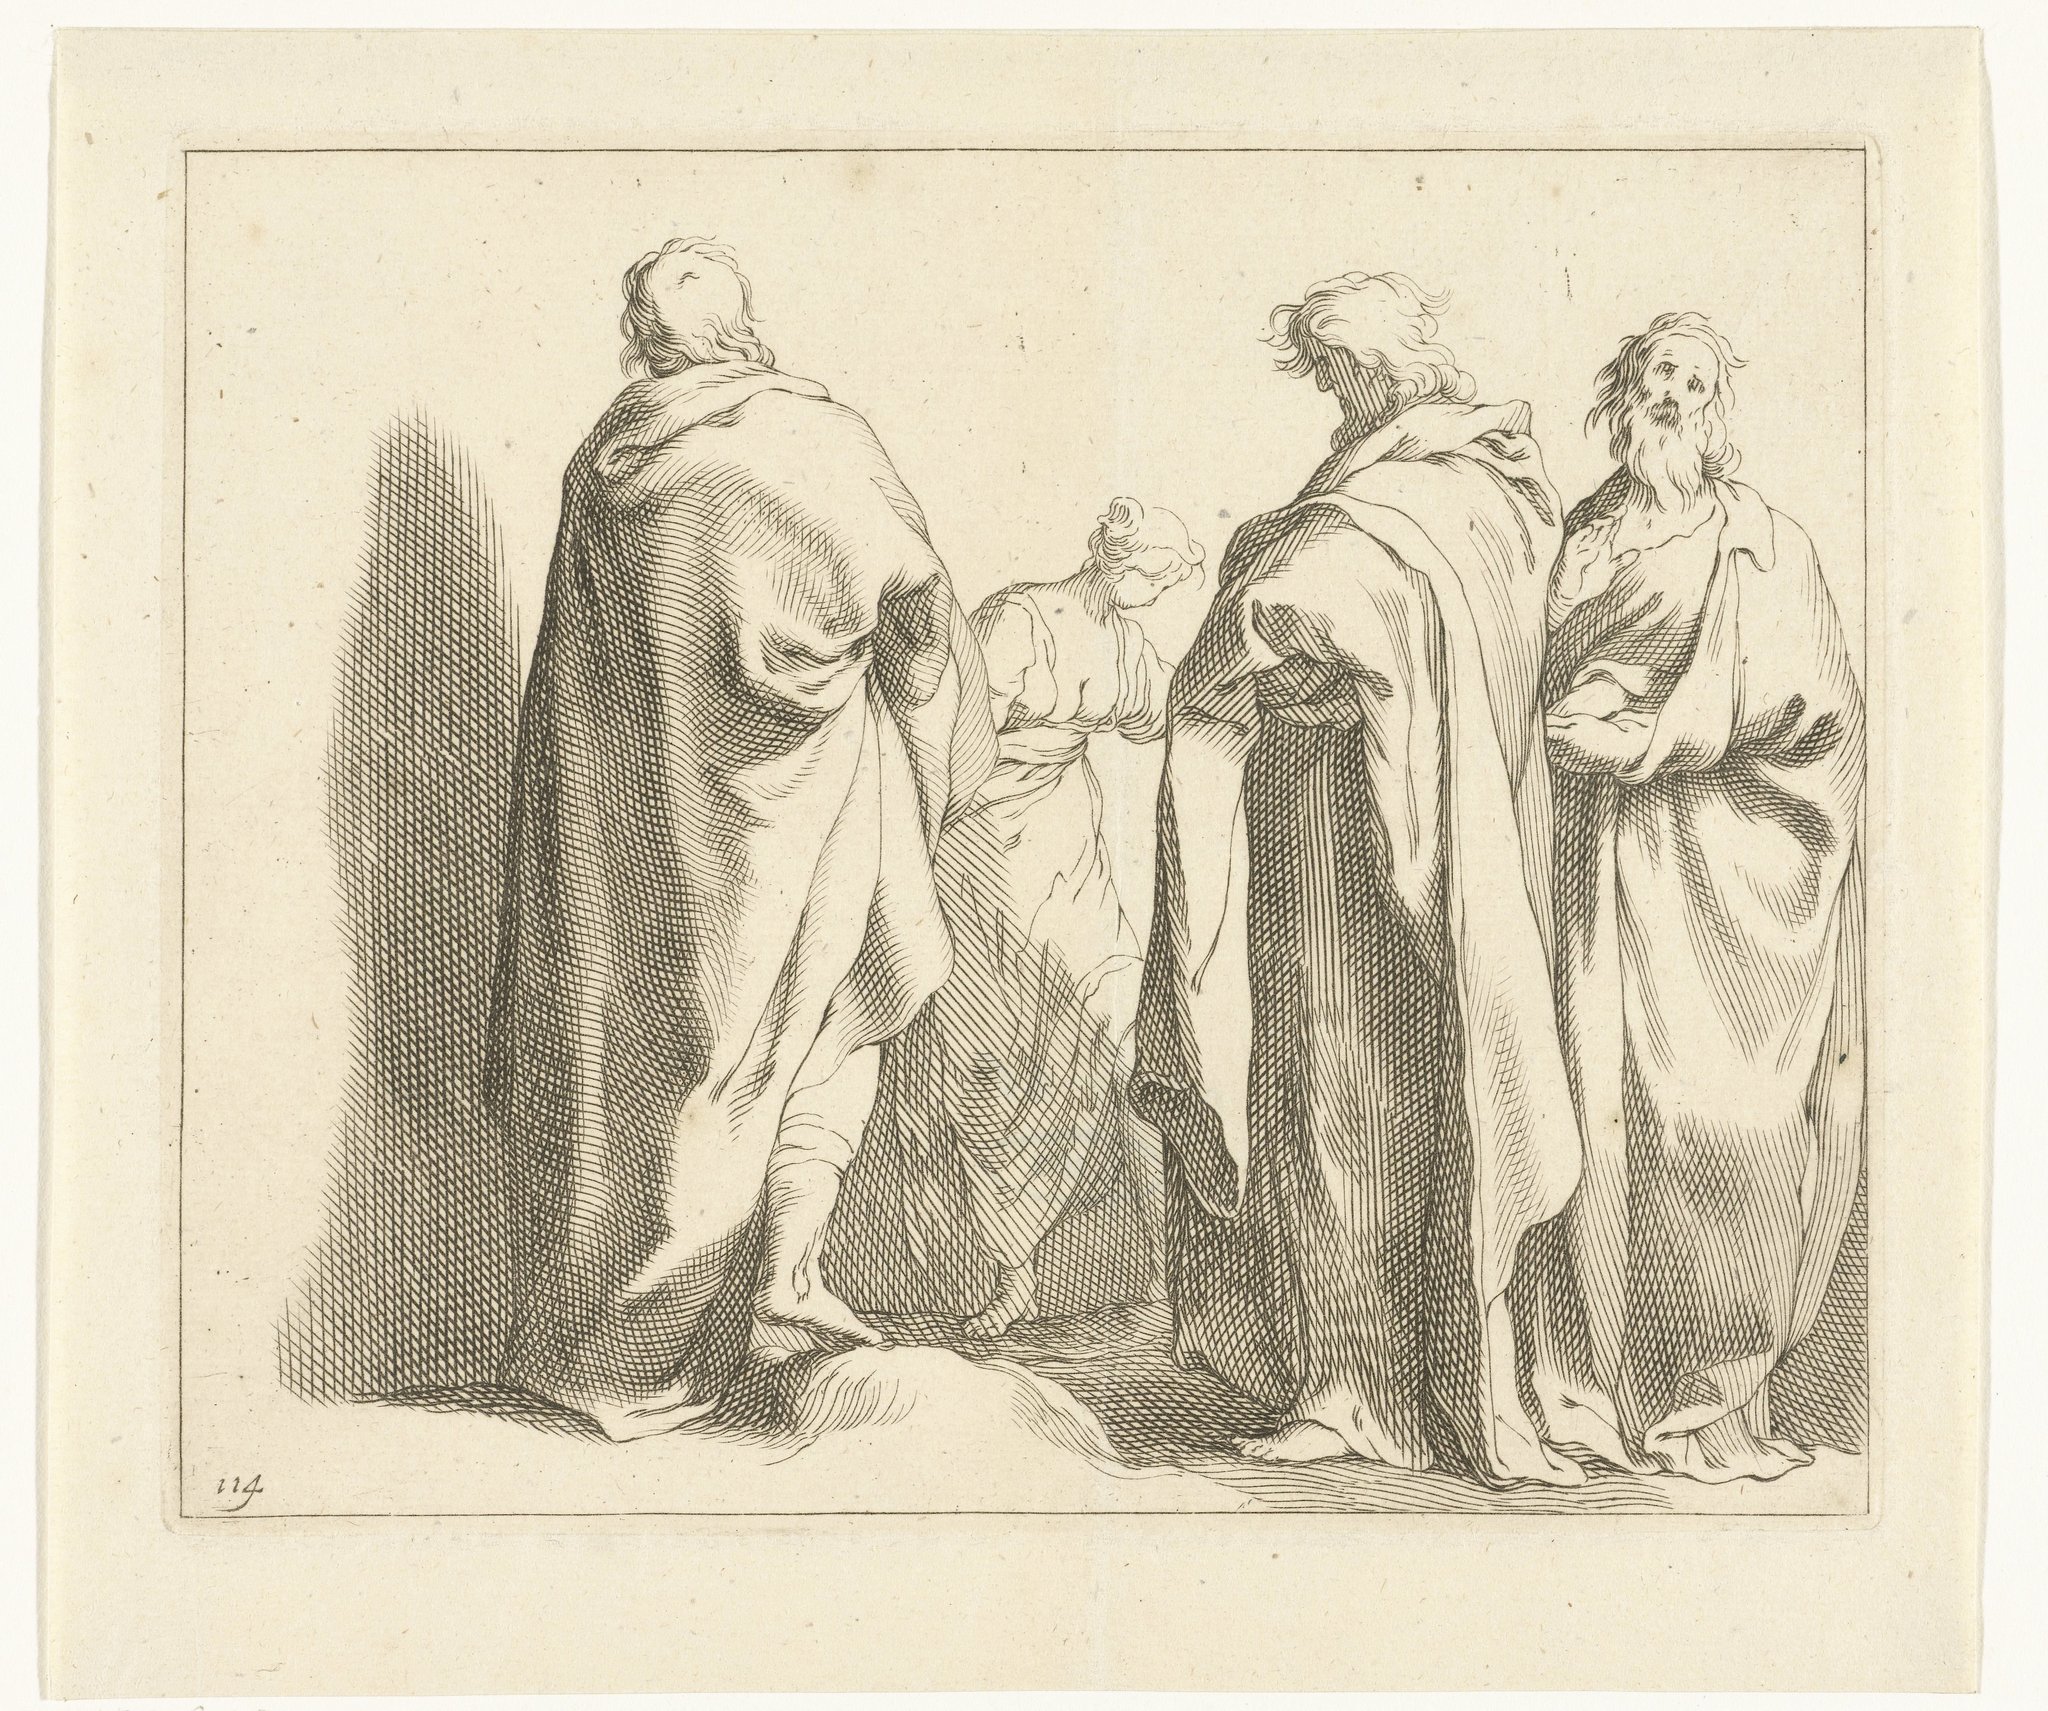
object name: print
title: Drie mannen en een vrouw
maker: frederick bloemaert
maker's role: print maker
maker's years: 1614-1669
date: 1650-1700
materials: paper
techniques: engraving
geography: utrecht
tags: human races; peoples; nationalities (+ men)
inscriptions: collector's mark: Lugt 2228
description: Drie mannen - op de rug gezien, zijwaarts en frontaal - met een vrouw meer op de achtergrond.